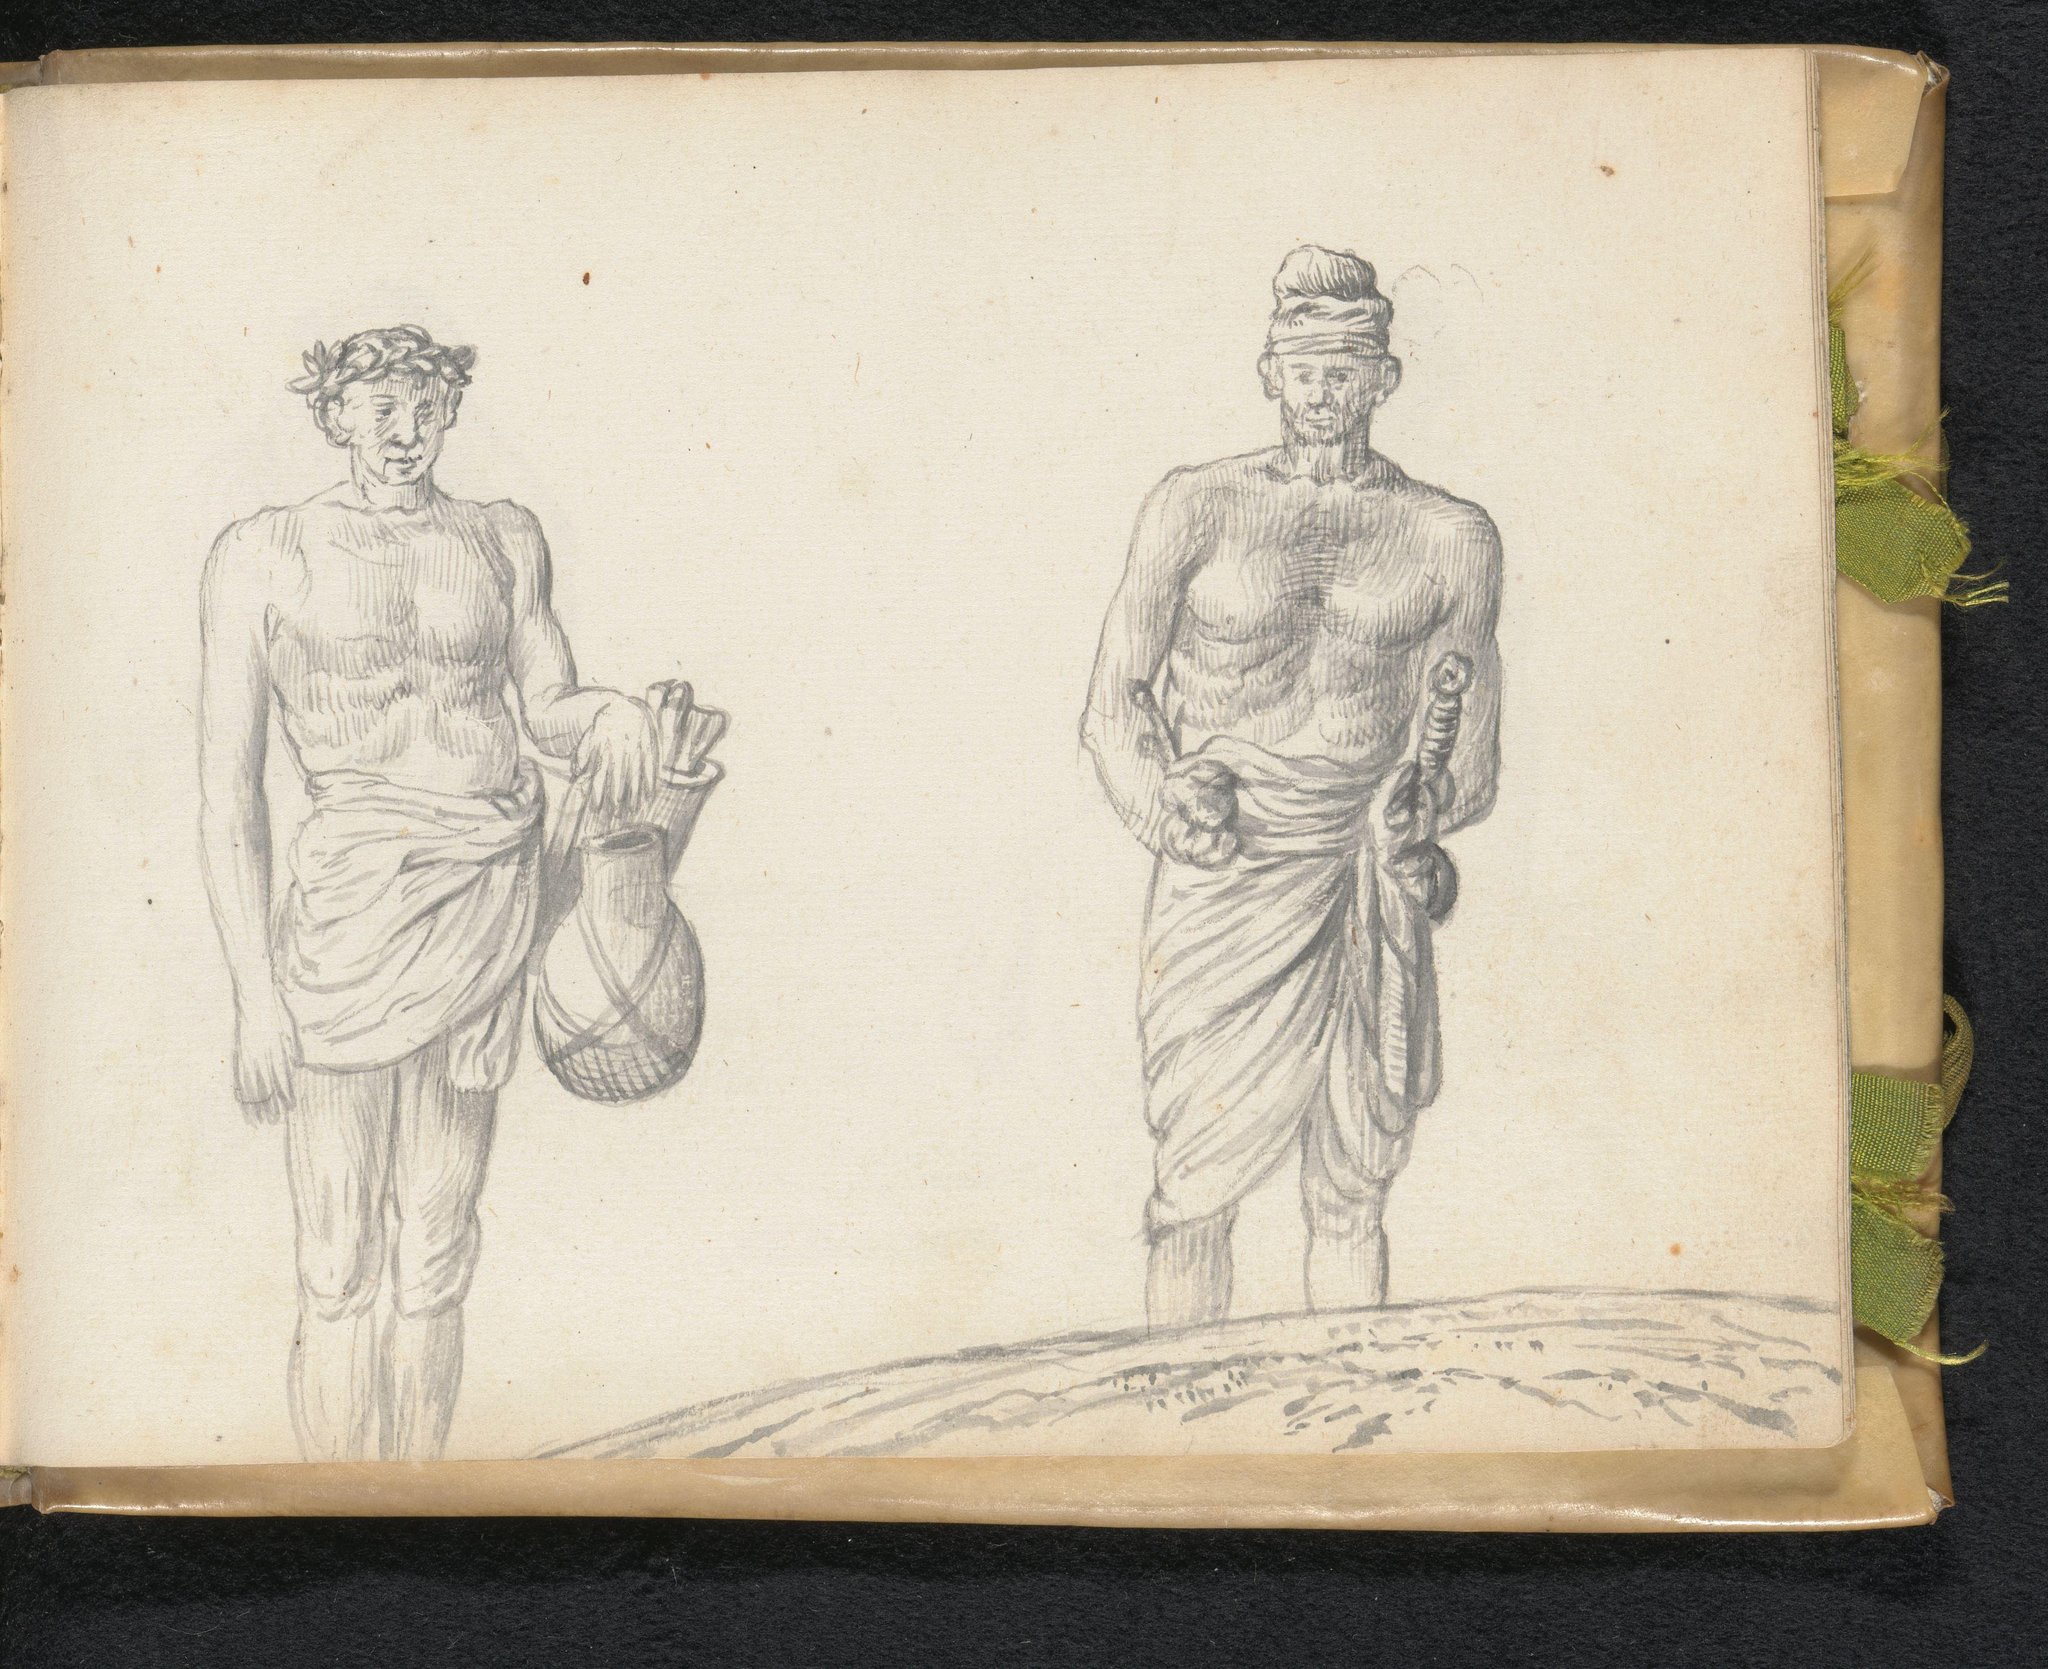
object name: sketchbook leaf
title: Toddy tapper and Sinhalese soldier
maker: esaias boursse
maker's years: 1631-1672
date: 1662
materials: ink, paper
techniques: brush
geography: sri lanka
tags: asiatic races and peoples (with name), 41d232(...) skirt (lungi), hacing and thrusting weapons (with name), sri lanka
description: Buiten op een helling staan twee mannen. De man links is een palmwijntapper. Hij draagt een dubbelgevouwen en hoog opgesjord heupkleed (veshti, lungi). Zijn bovenlijf en benen zijn onbedekt. Op de linkerheup draagt hij een aardenwerken pot (labu katey) voor het verzamelen van de palmwijn (tolwagen of toddy), opgehangen in een net van koorden, waarmee de pot gedragen kan worden. Achter de pot hangt een houten koker met een bundel gereedschappen: messen om de bloem van de kokospalm in te snijden en een hamer (thalanaya) om de bloem plat te slaan. Om het hoofd draagt de man een krans van bladeren, mogelijk ter afwering van insecten. De man man rechts is een Singalese huursoldaat (lascorijn). Hij gaat gekleed in een knielang heupkleed (veshti, lungi), op Singalese wijze gedragen. Zijn voeten gaan schuil achter de getekende helling. Het bovenlijf is onbedekt. Aan zijn linkerzij hangt een kastane (kort zwaard) waarvan het handvest hoog uitsteekt. Op zijn rechterzij steekt een dolk boven de ingestopte taillerand uit. Op het hoofd draagt de man een hoge muts met omgeslagen rand. Blad 112 uit een schetsboek met 117 bladen.